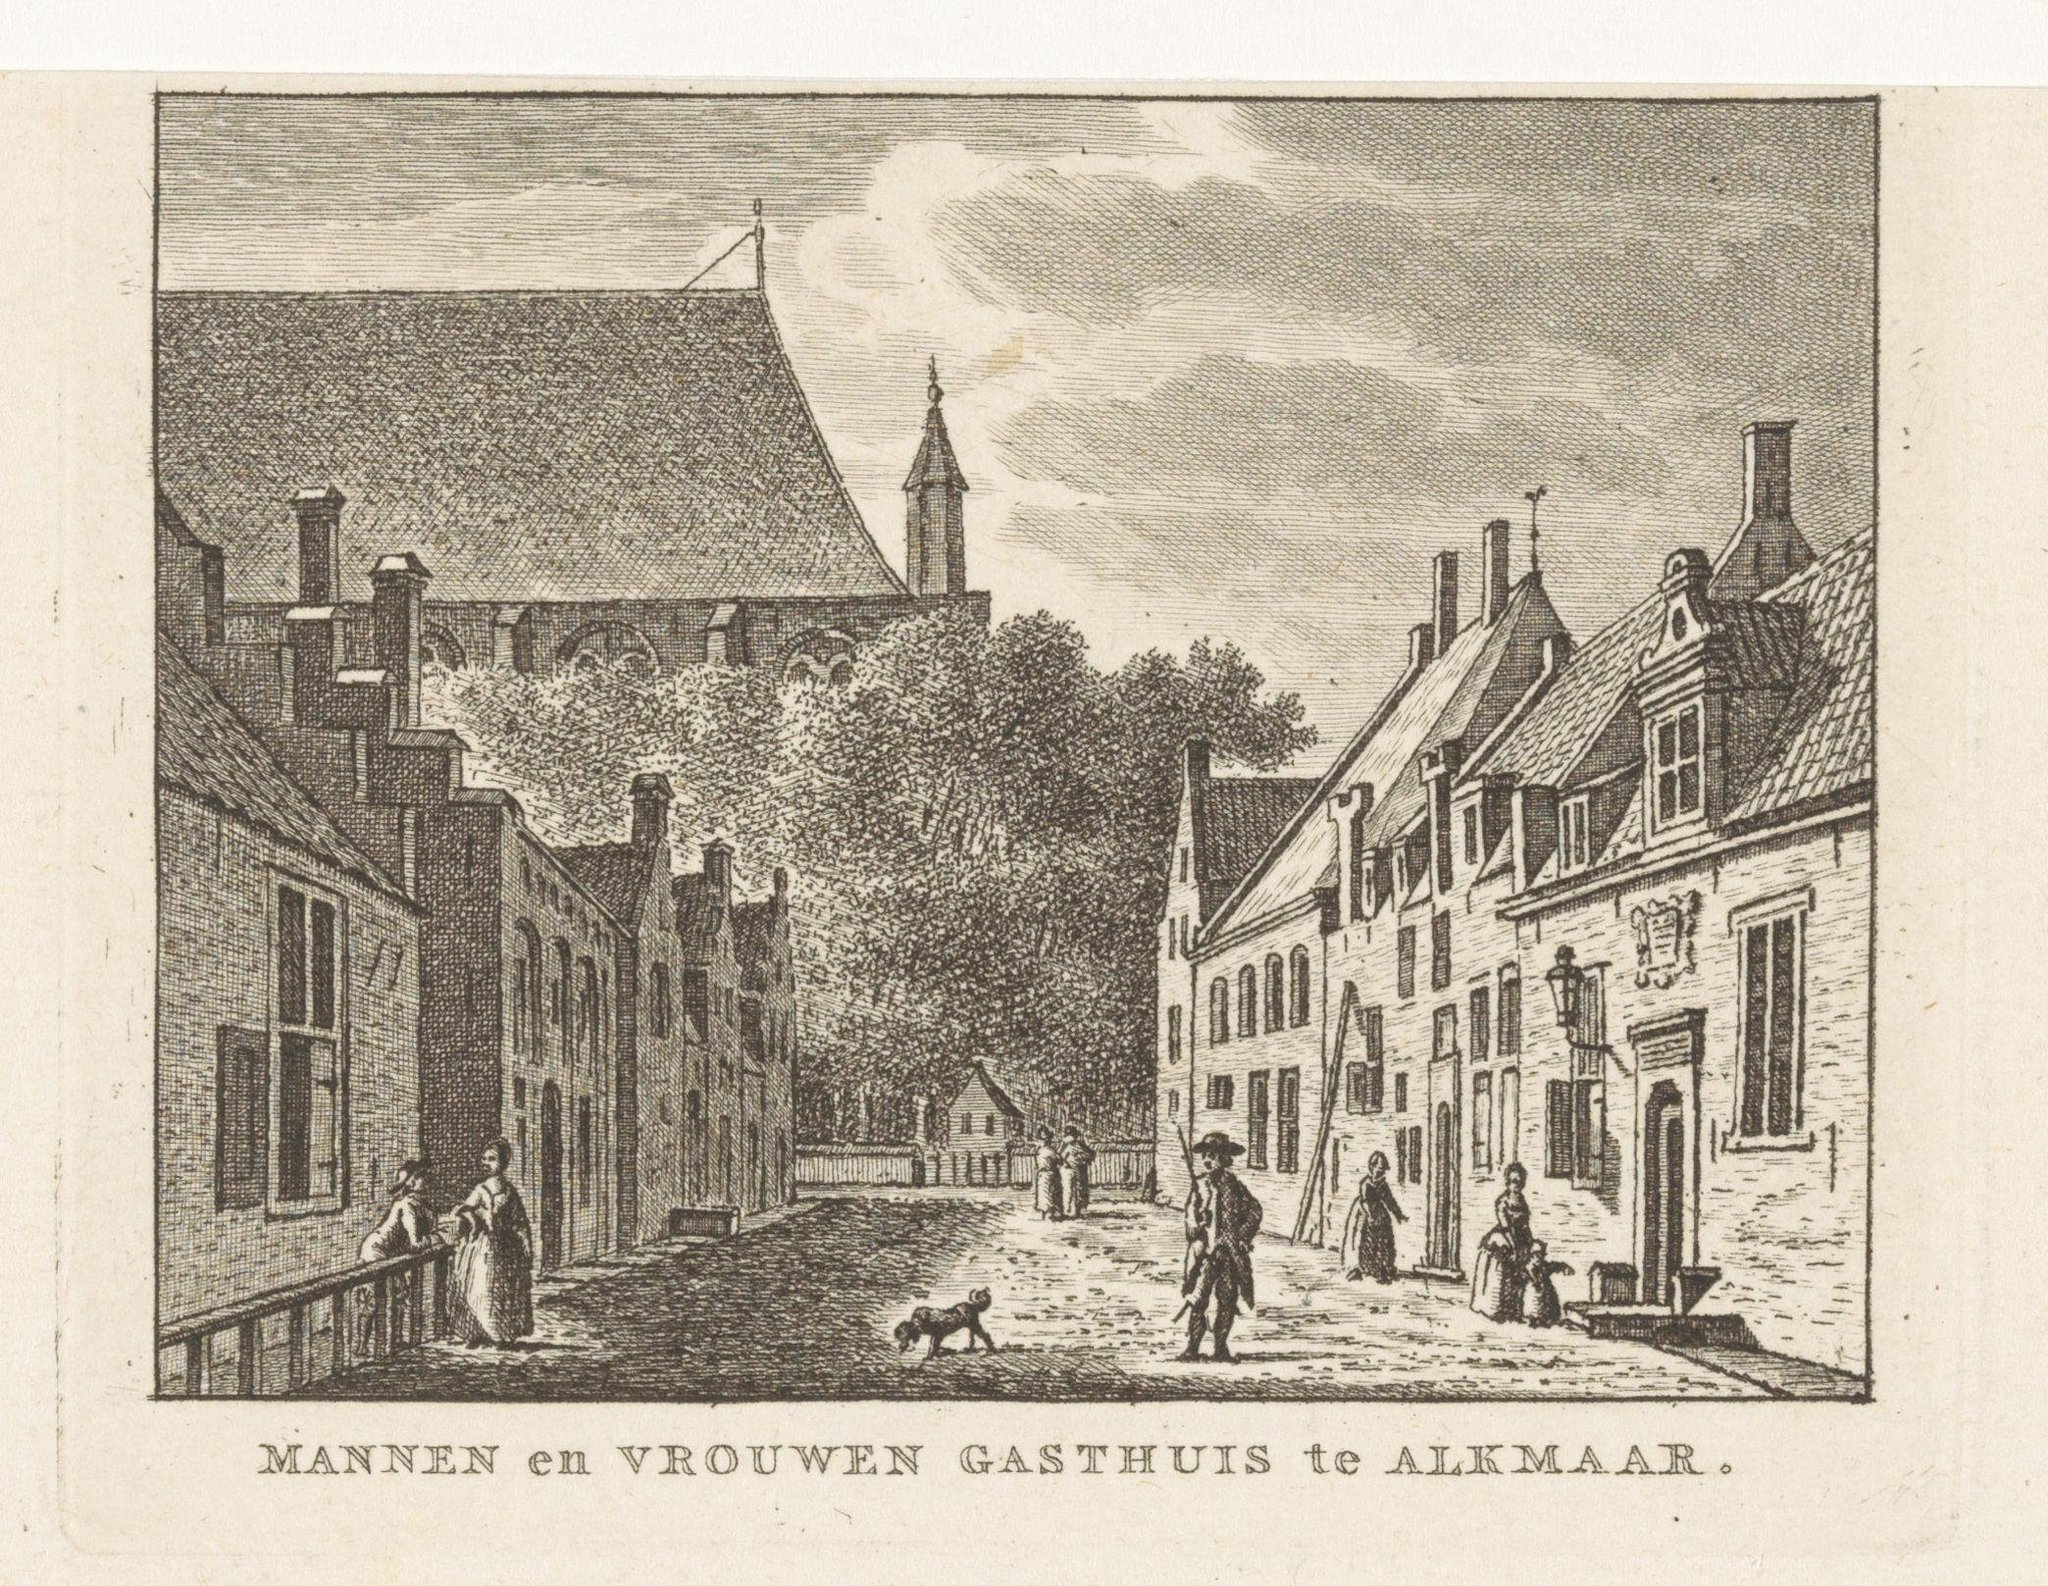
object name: print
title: Mannen en Vrouwen gasthuis te Alkmaar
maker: carel frederik bendorp (i)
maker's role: print maker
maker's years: 1736-1814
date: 1786-1792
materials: paper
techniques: engraving, etching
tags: church (exterior), hospital, public road (+ city(-scape) with figures, staffage)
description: Prent uit: Vaderlandsche gezichten, of afbeeldingen van den tegenwoordigen staat der Vereenigde Nederlanden (…). Amsterdam: Hendrik Gartman, Willem Vermandel en Jan Willem Smit, 1786-1792. Uitgegeven in afleveringen met ieder een eigen bifolium en inhoudsopgave. Alle prenten in deze publicatie zijn gegraveerd door Carel Frederik Bendorp (I) en, in de meeste gevallen, gebaseerd op tekeningen van Jan Bulthuis.